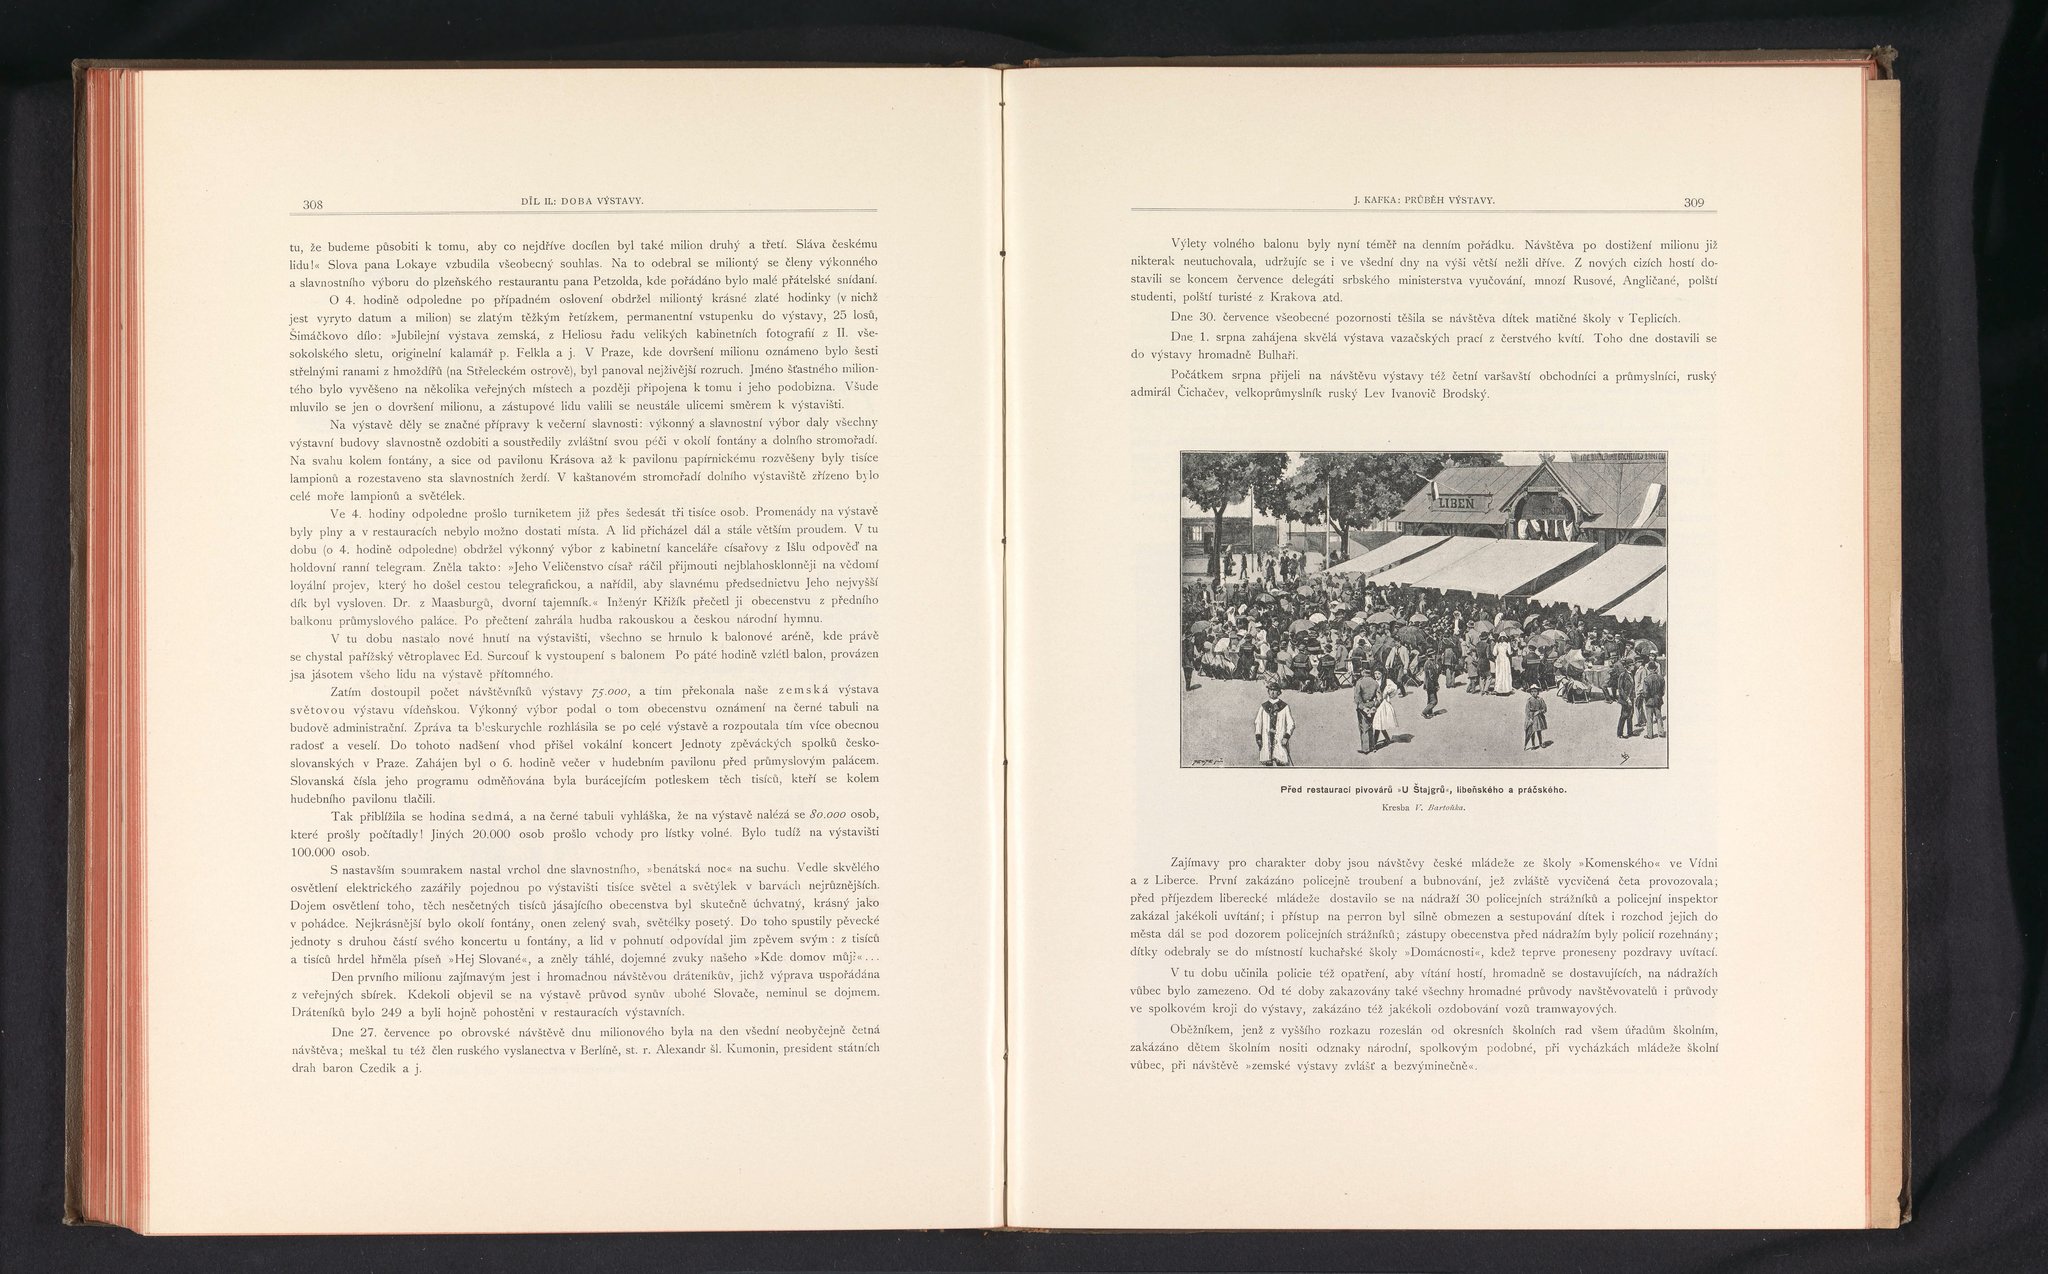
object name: page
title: Pred restauraci pivovaru ,,U Stajgru" libenského a pracského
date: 1891-1893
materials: paper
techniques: autotype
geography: výstaviště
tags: façade (of house or building), restaurant